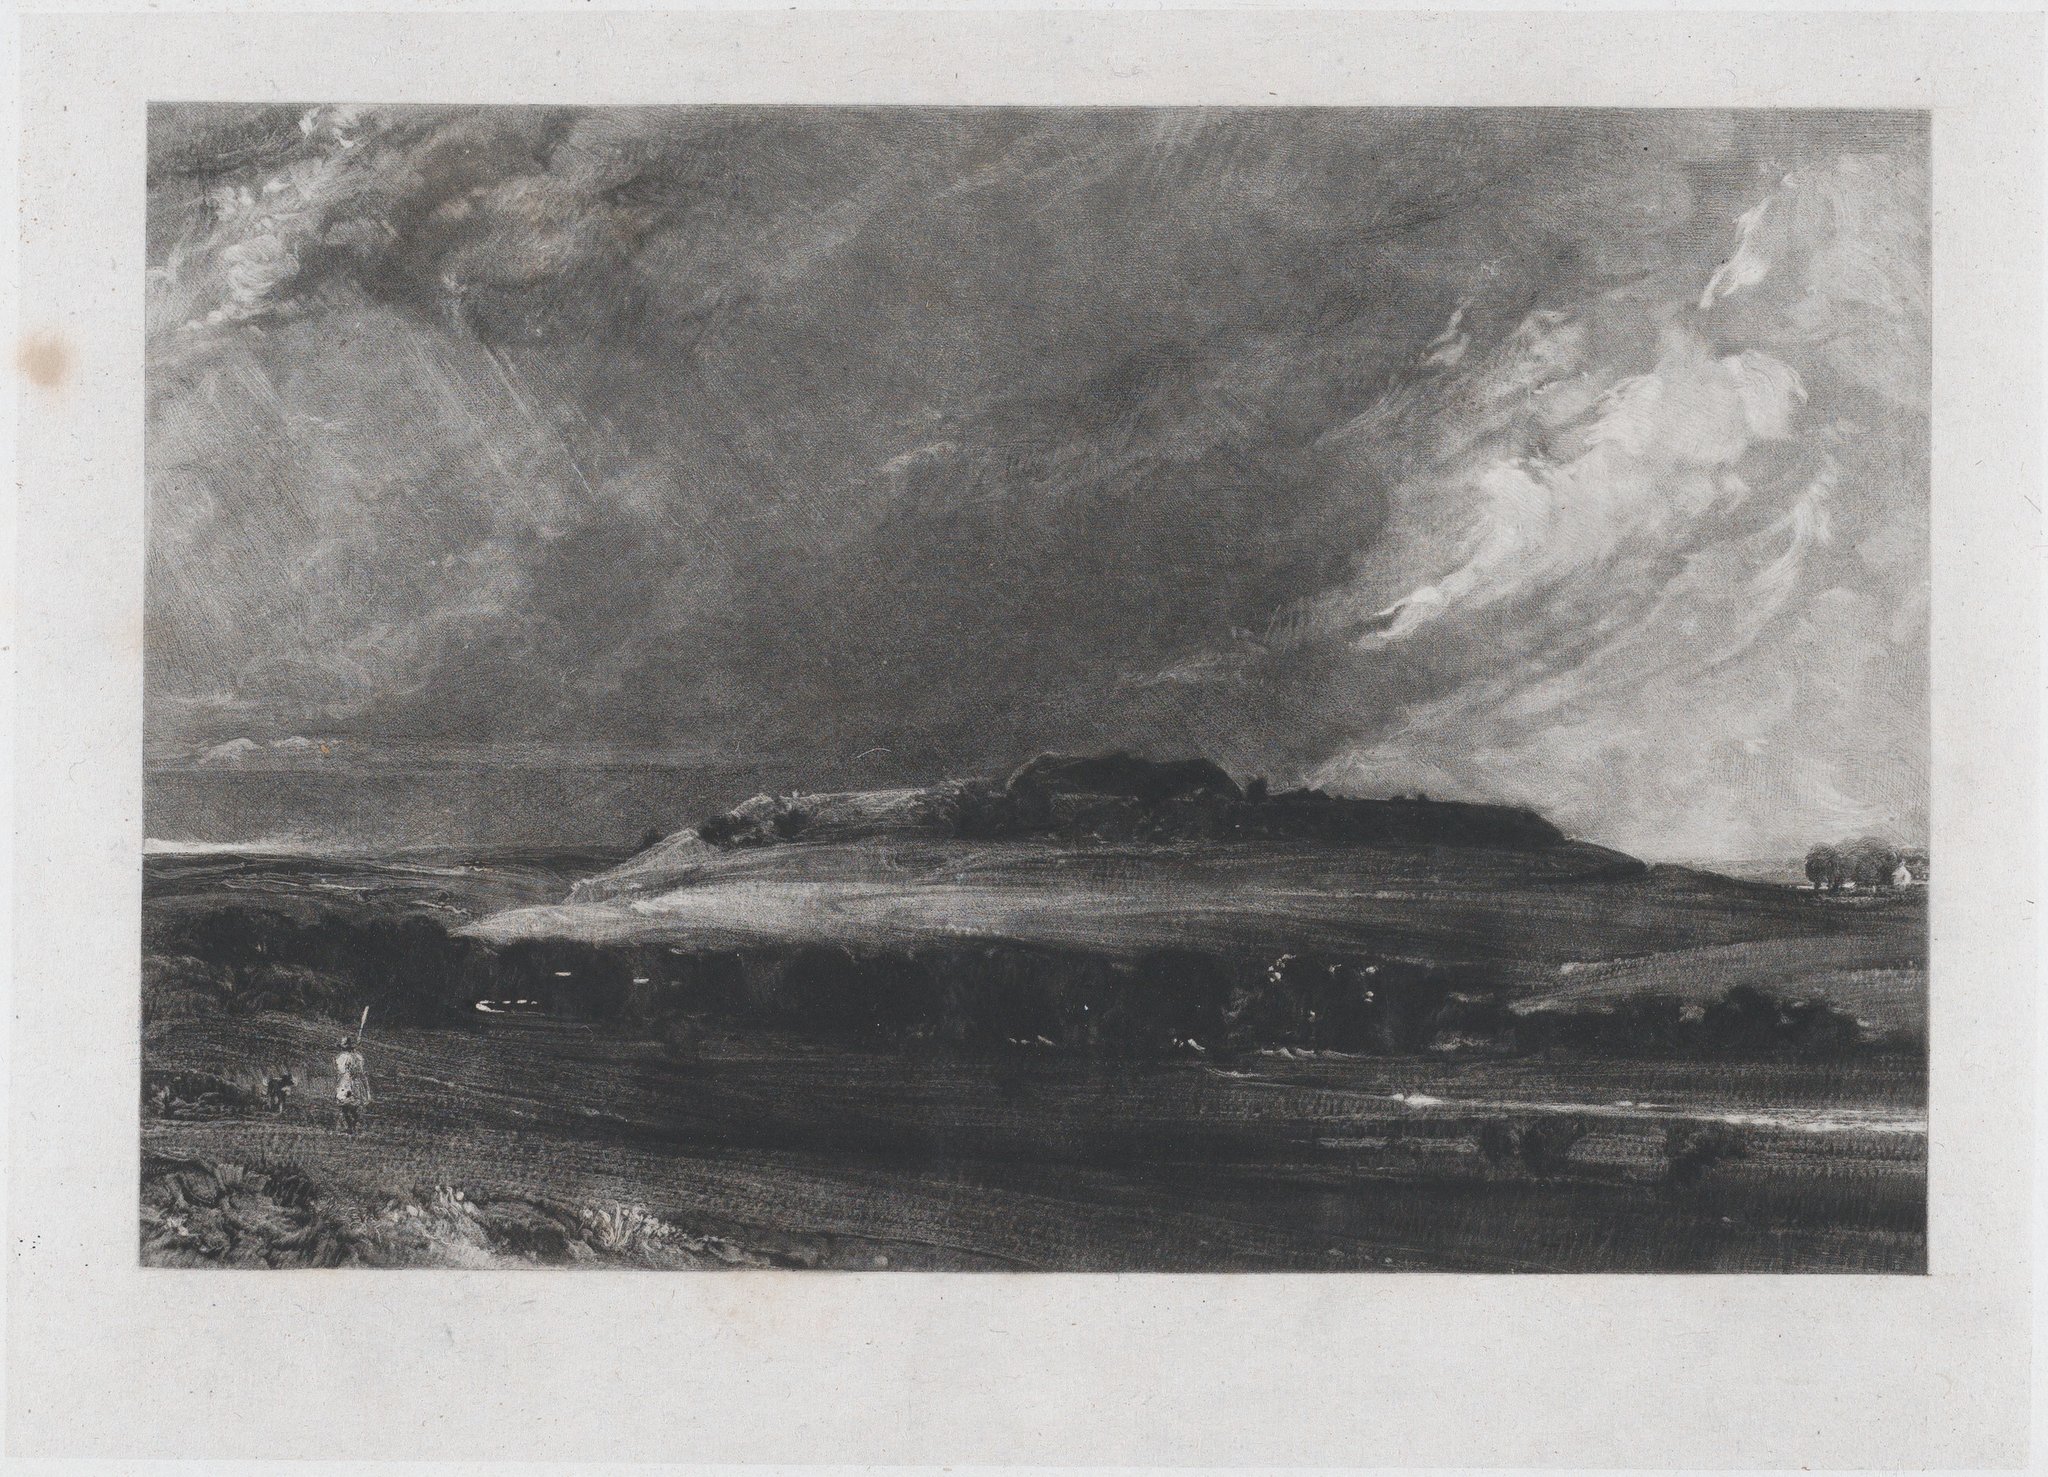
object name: print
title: Old Sarum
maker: david lucas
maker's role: artist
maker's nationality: british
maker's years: 1802-1881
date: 1830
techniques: printmaking, drypoint, mezzotint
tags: seascapes